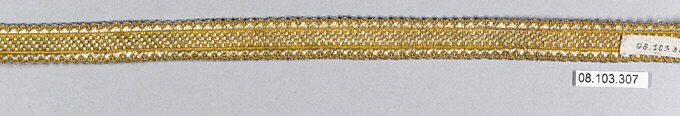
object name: galloon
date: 1601-1800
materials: silk